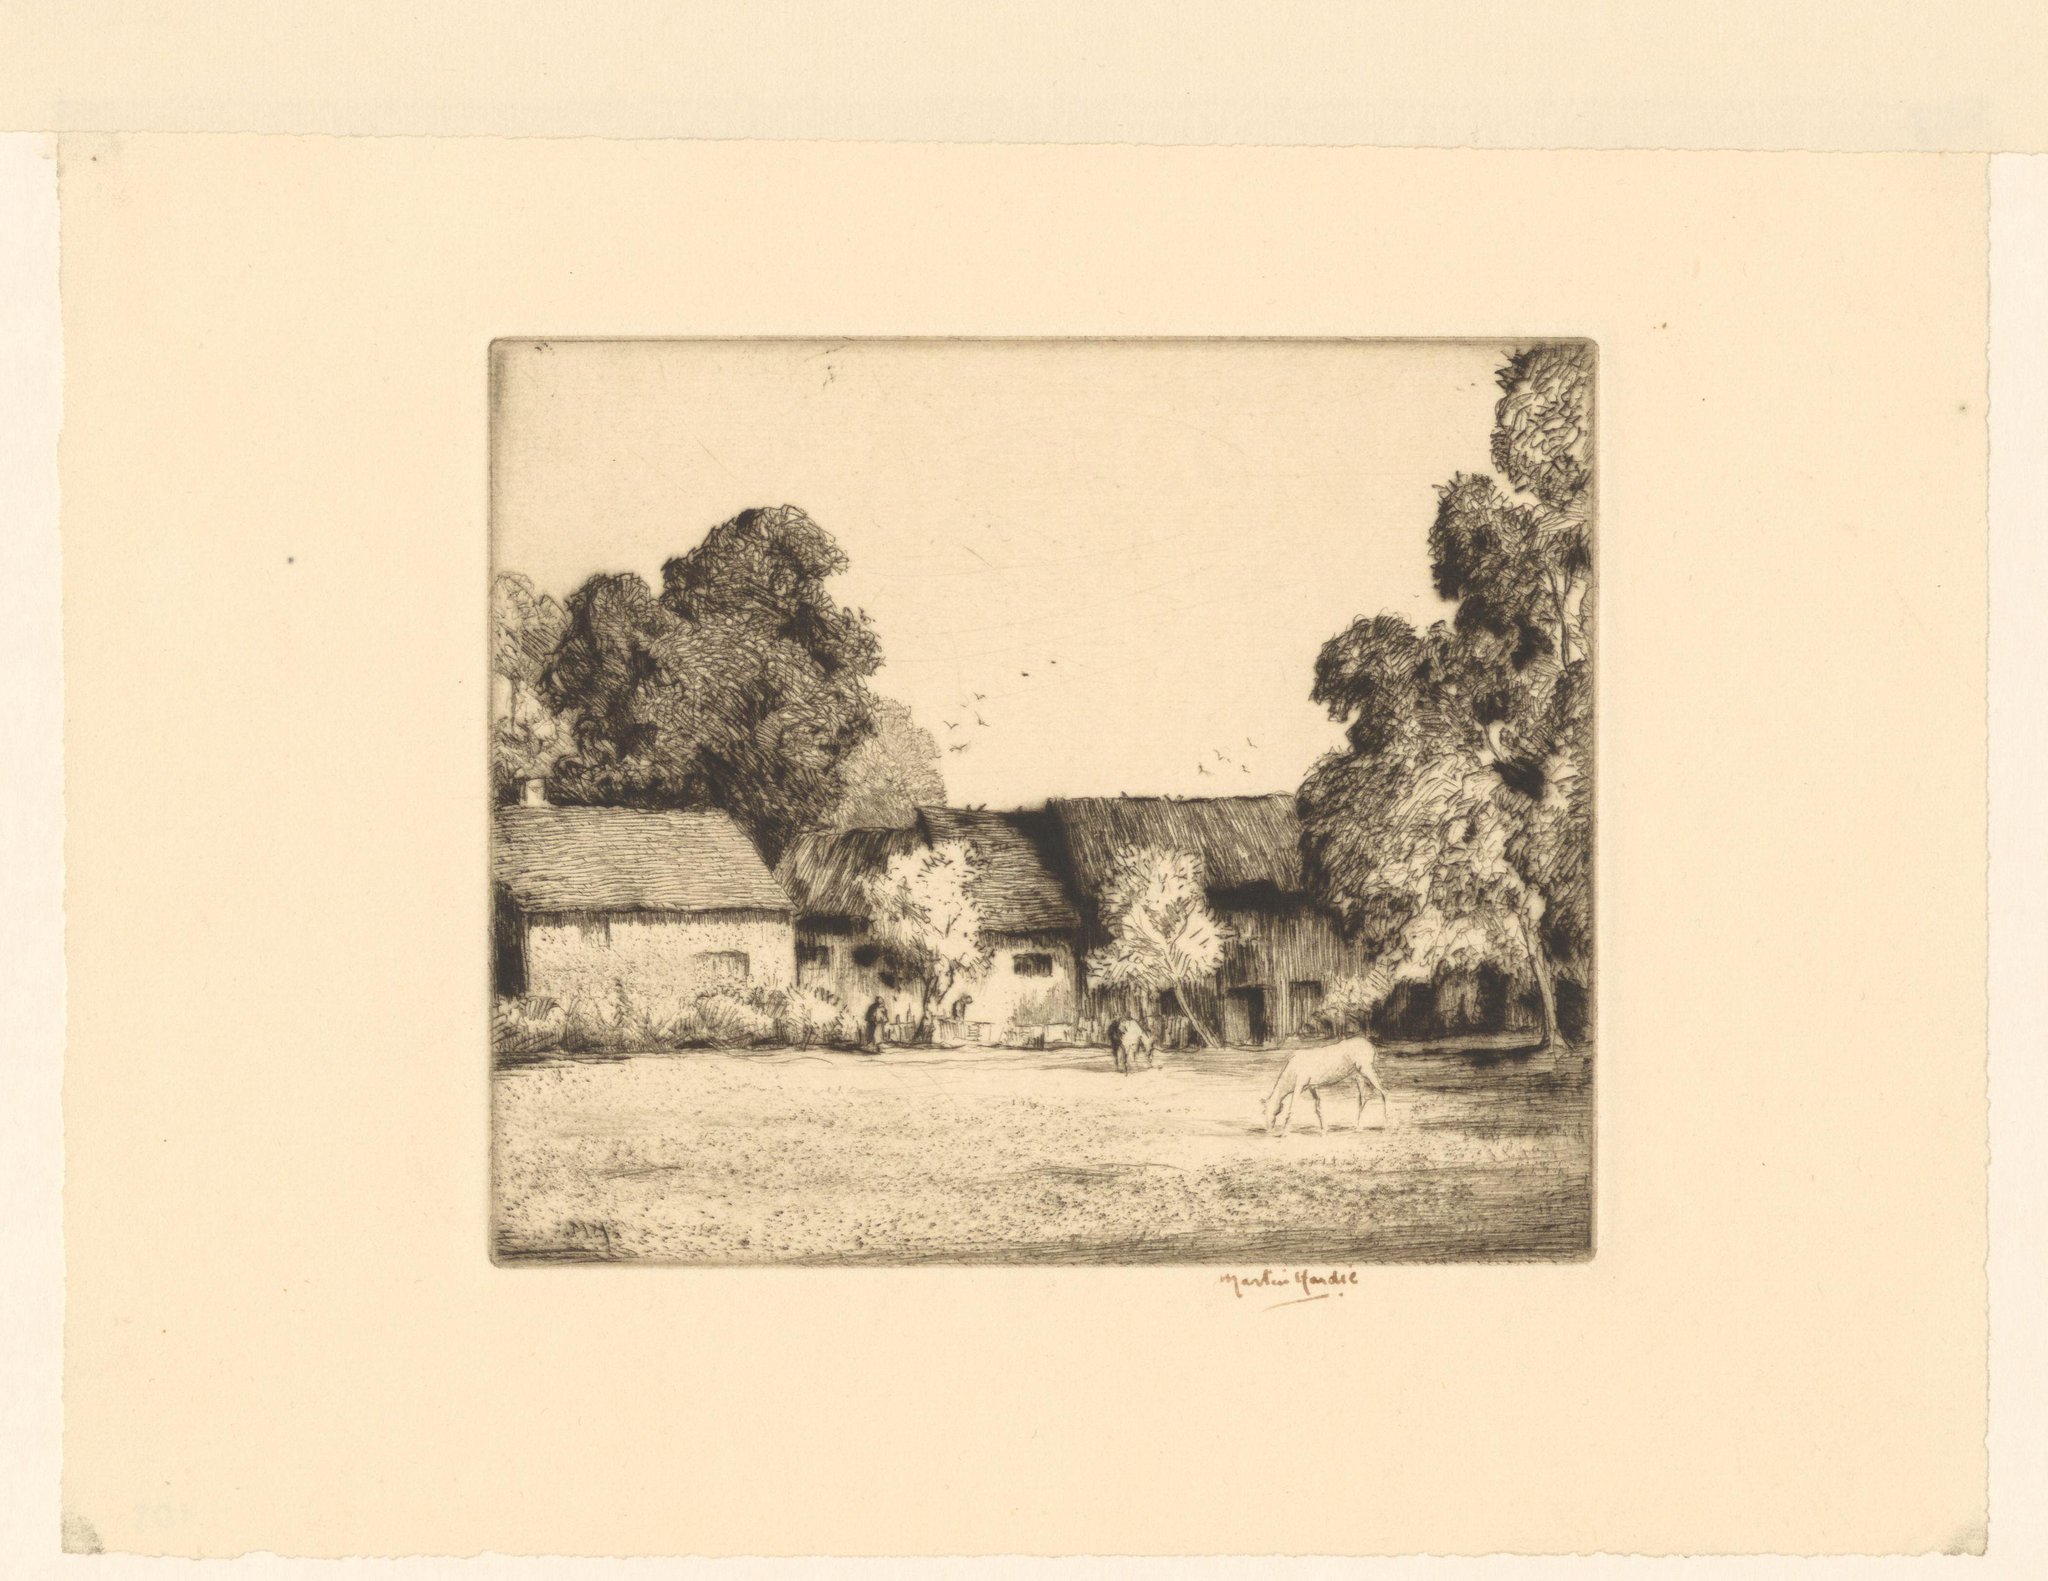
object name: print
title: The East Coast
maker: martin hardie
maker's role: print maker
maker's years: 1875-1952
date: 1924-1925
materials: paper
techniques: drypoint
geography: suffolk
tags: farm (building)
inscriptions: collector's mark: Lugt 2228, collector's mark: Lugt 2760, annotation: ‘Martin Hardie’